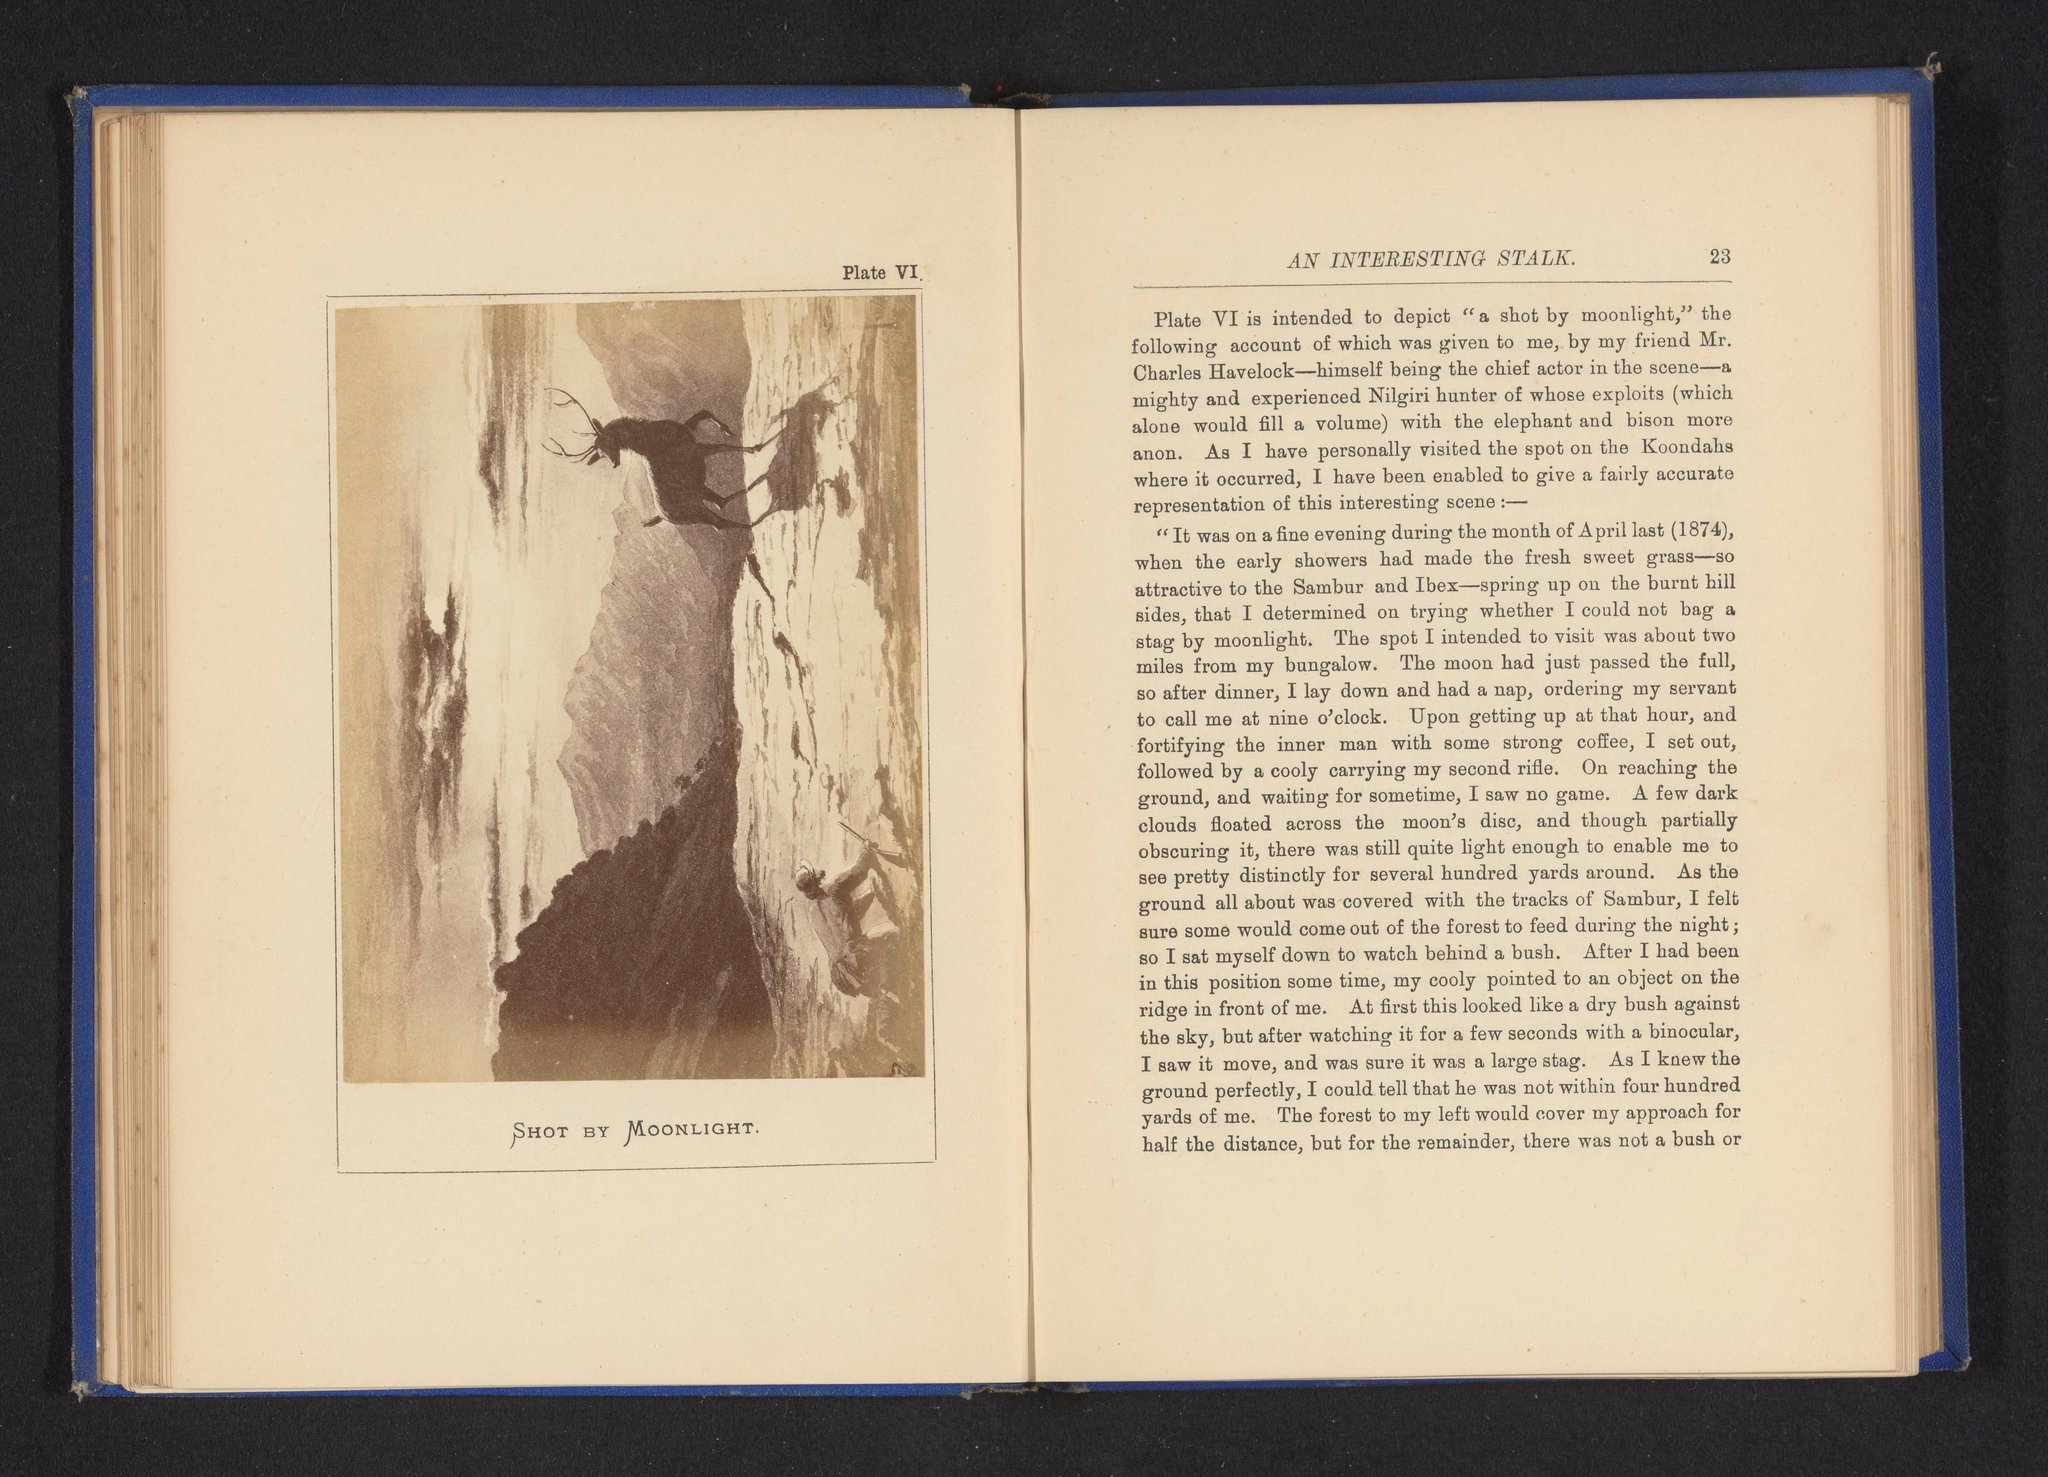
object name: photograph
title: Shot by moonlight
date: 1870-1880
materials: photographic support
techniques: albumen print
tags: drawing, sketch, hoofed animals: deer, hunt ~ mammals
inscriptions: number: ‘Plate VI.’